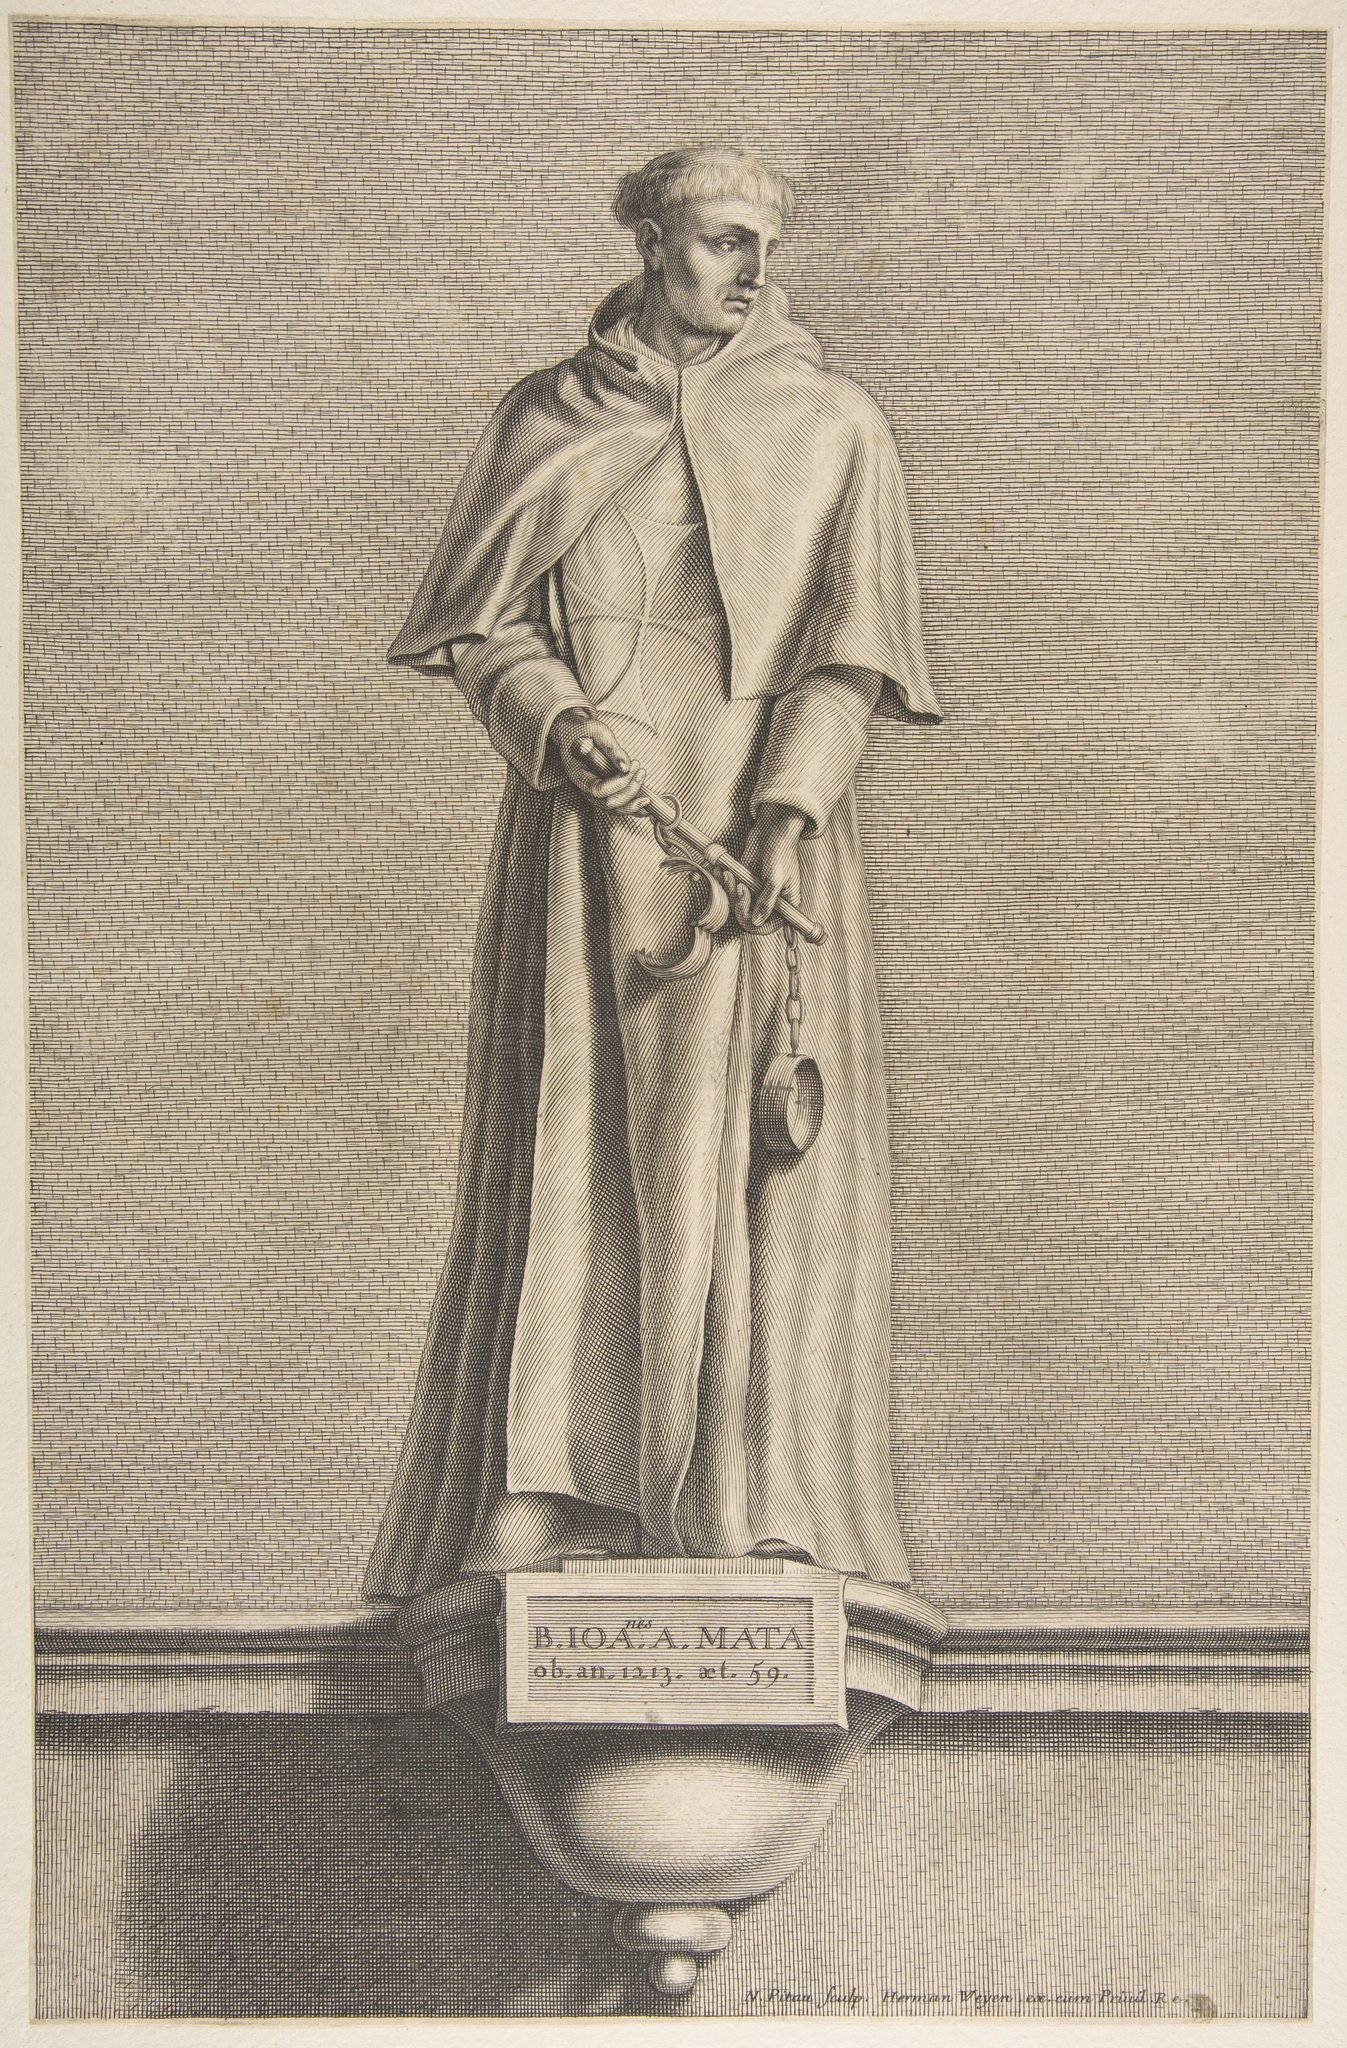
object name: print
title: The Blessed John Mata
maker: nicolas pitau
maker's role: artist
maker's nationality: french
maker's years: 1670-1724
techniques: engraving, etching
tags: men,saints